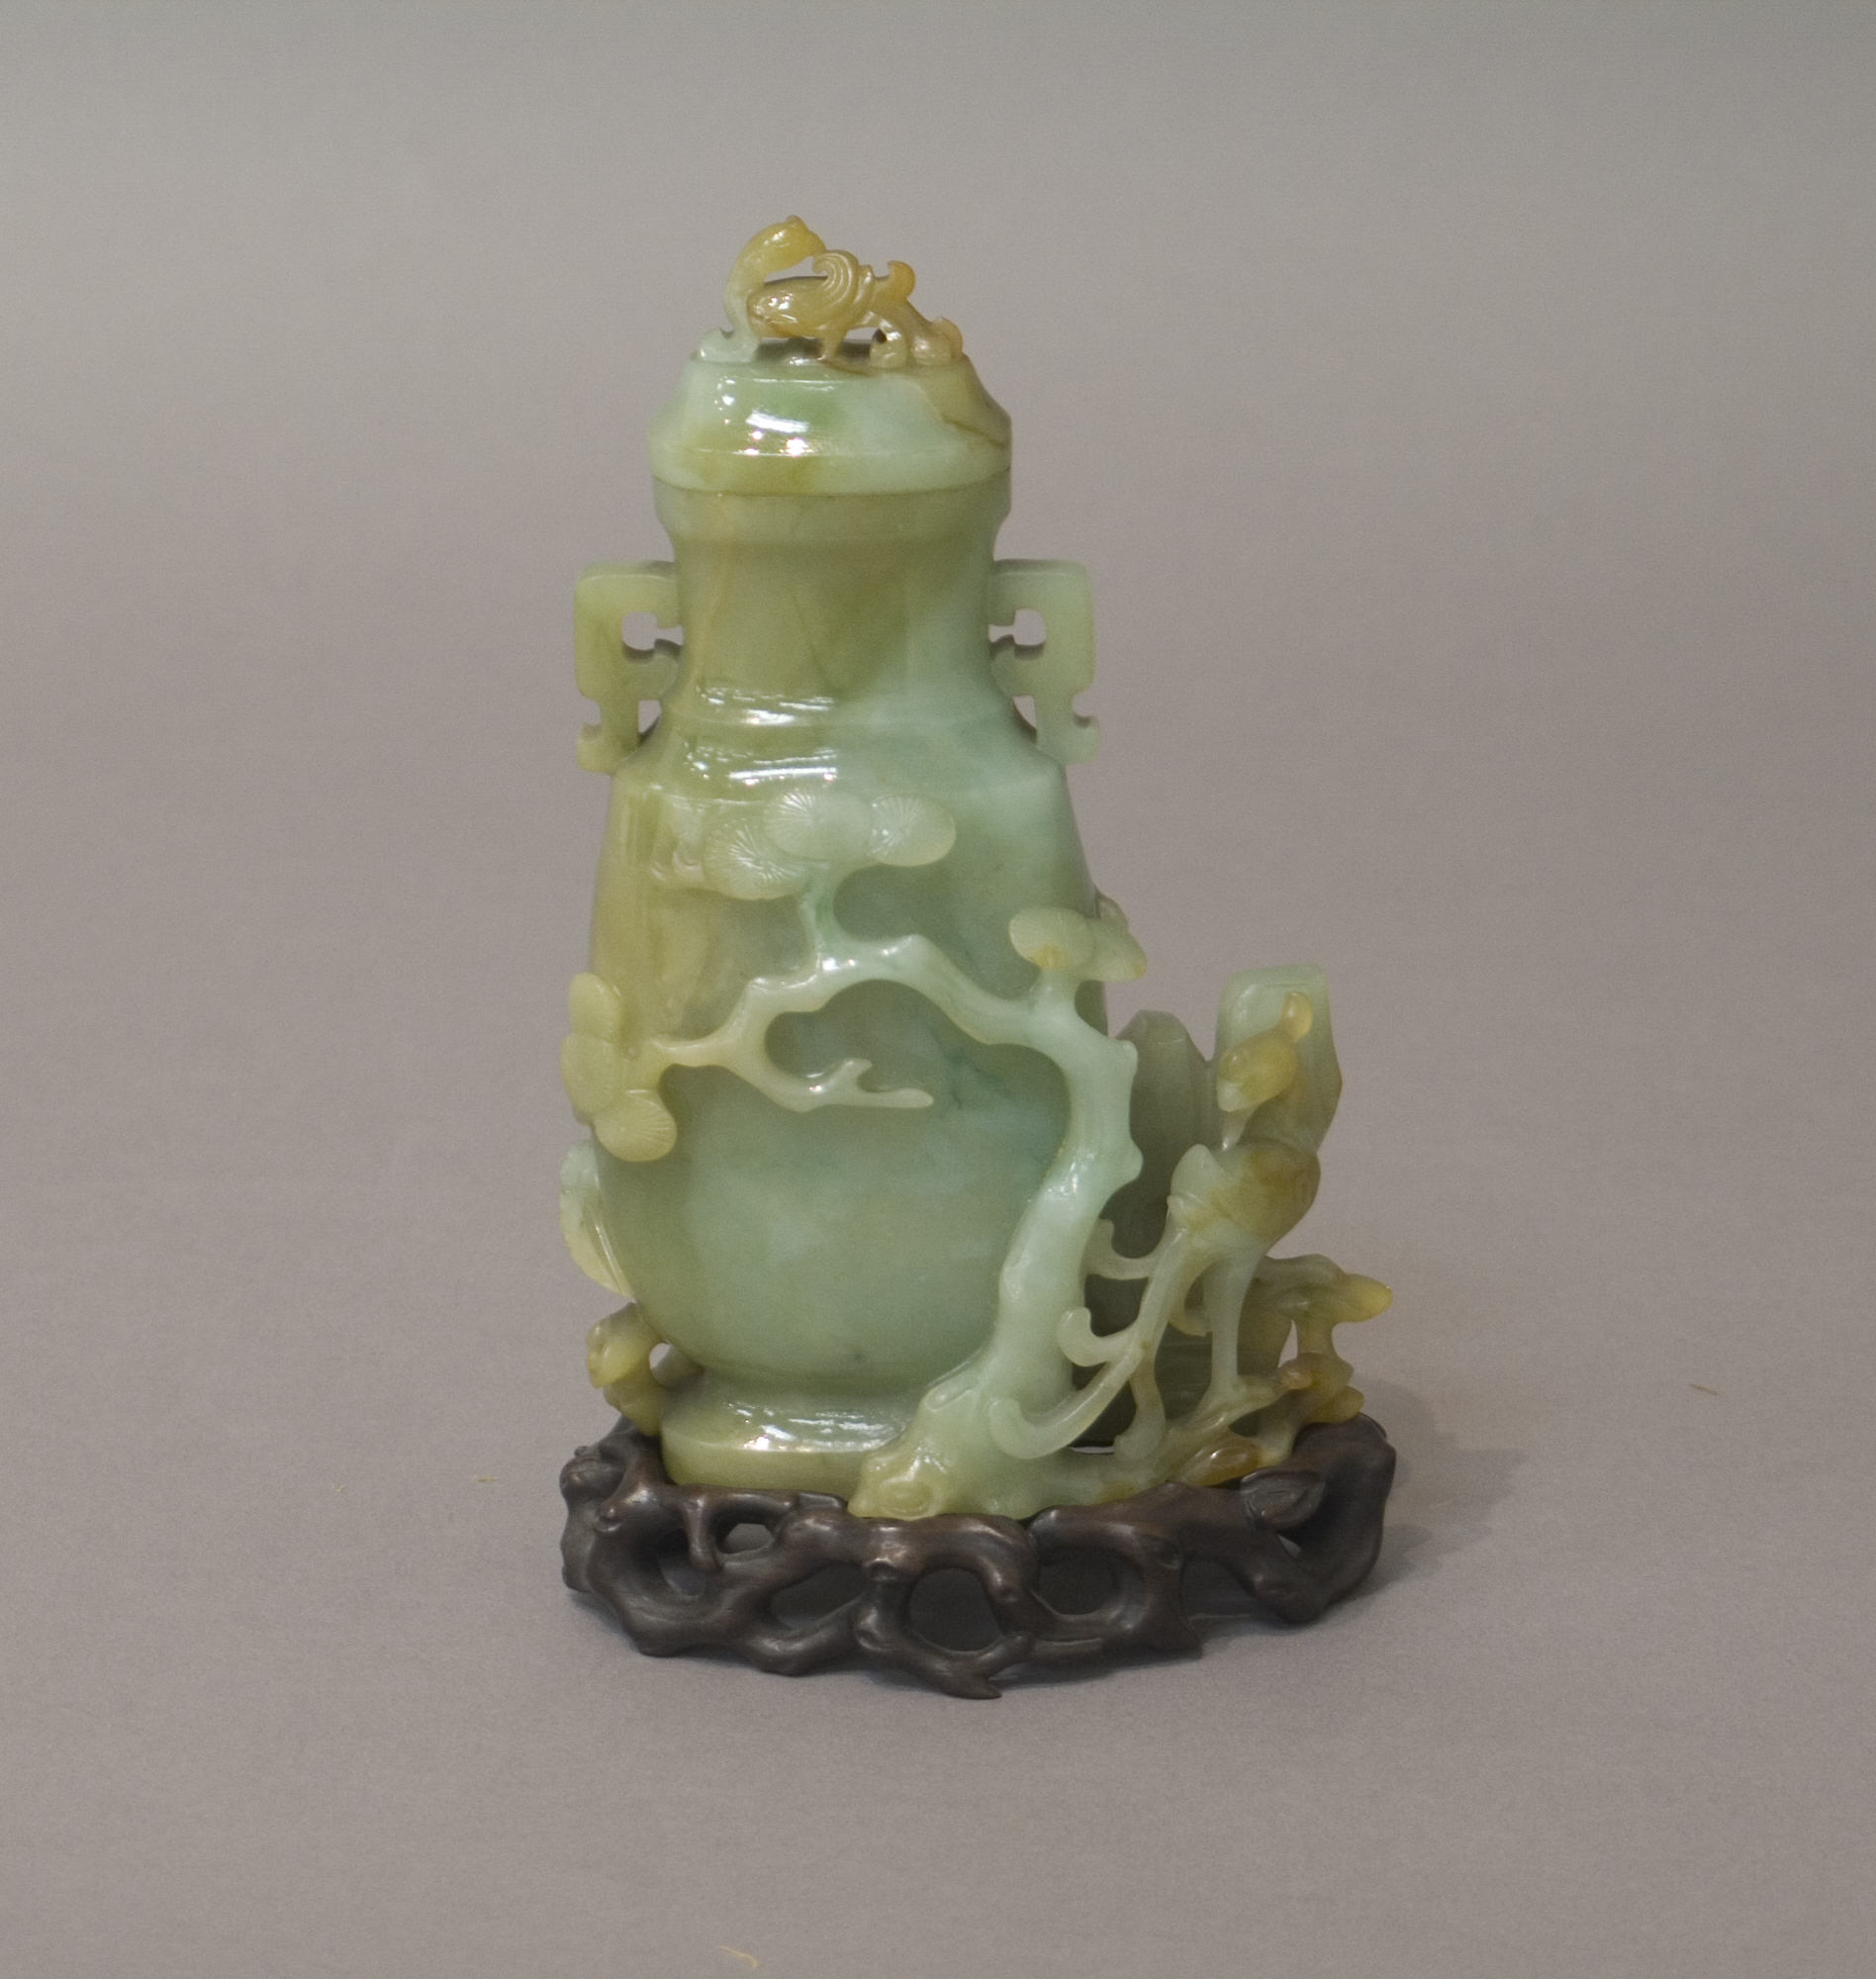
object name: vase with cover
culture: chinese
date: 1662-1722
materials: gemstone, jade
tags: trees